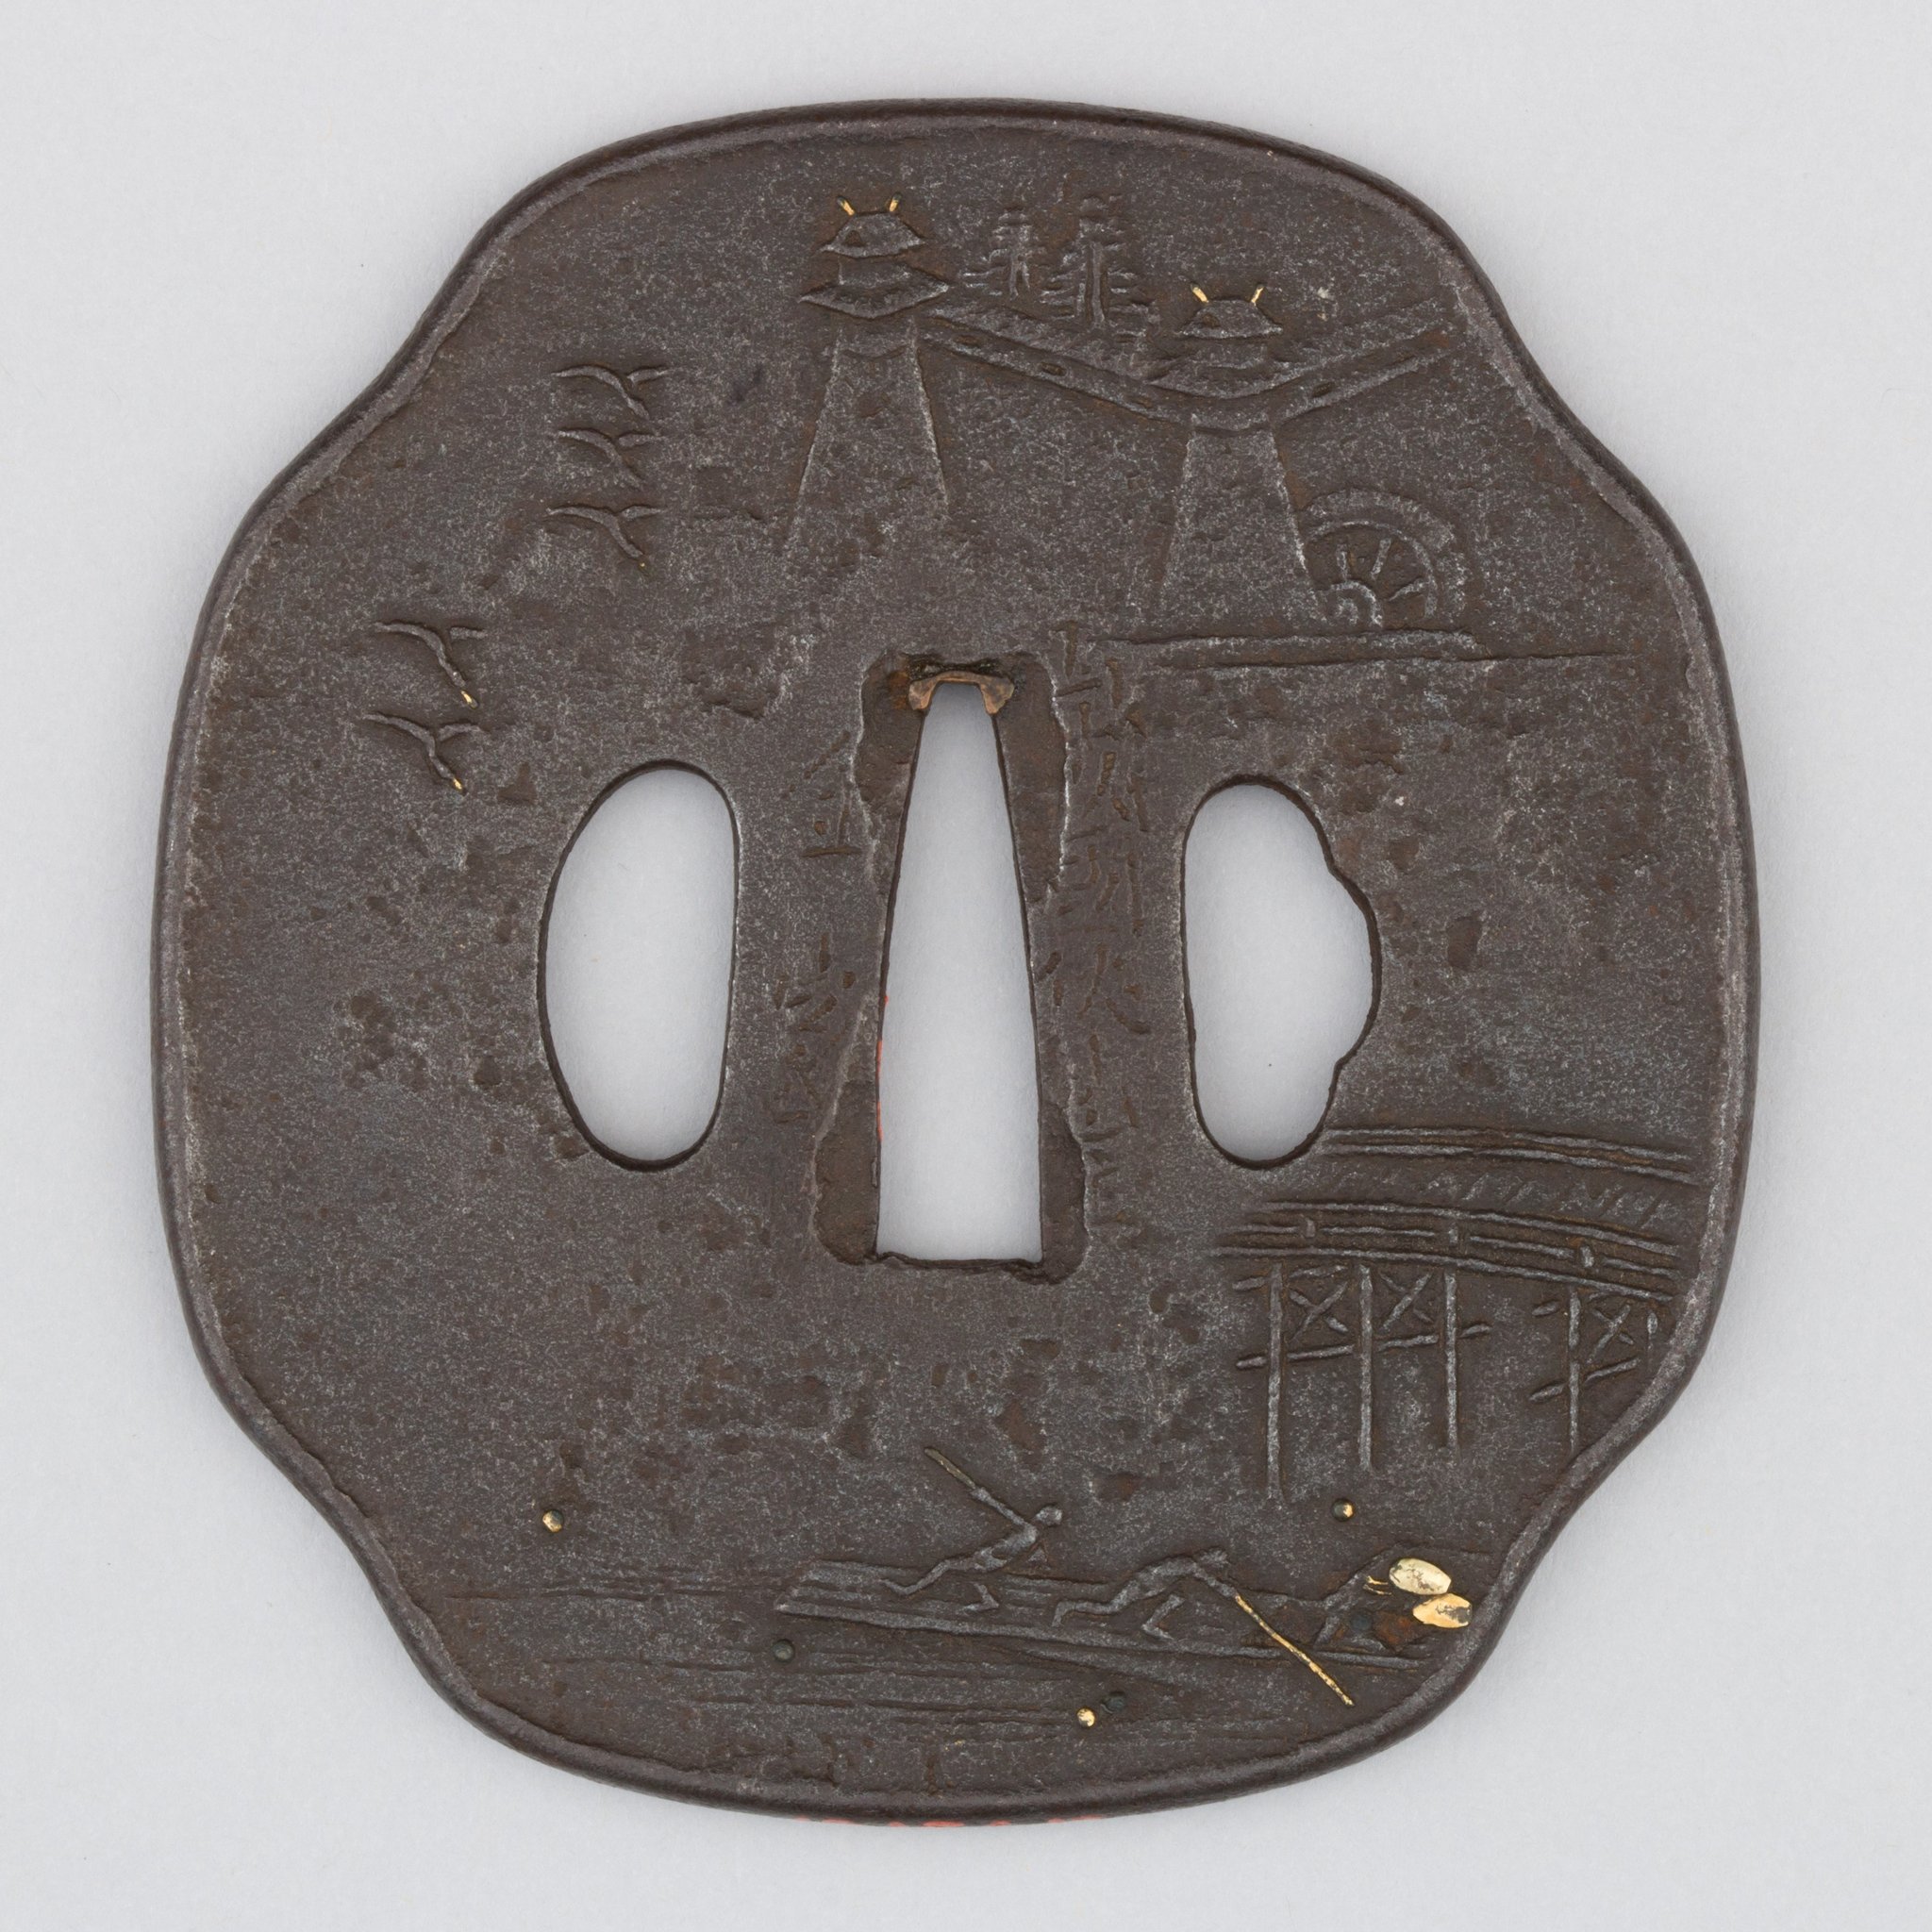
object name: sword guard tsuba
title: Sword Guard (Tsuba)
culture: japanese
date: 1601-1650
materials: copper, iron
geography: japan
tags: geese,boats